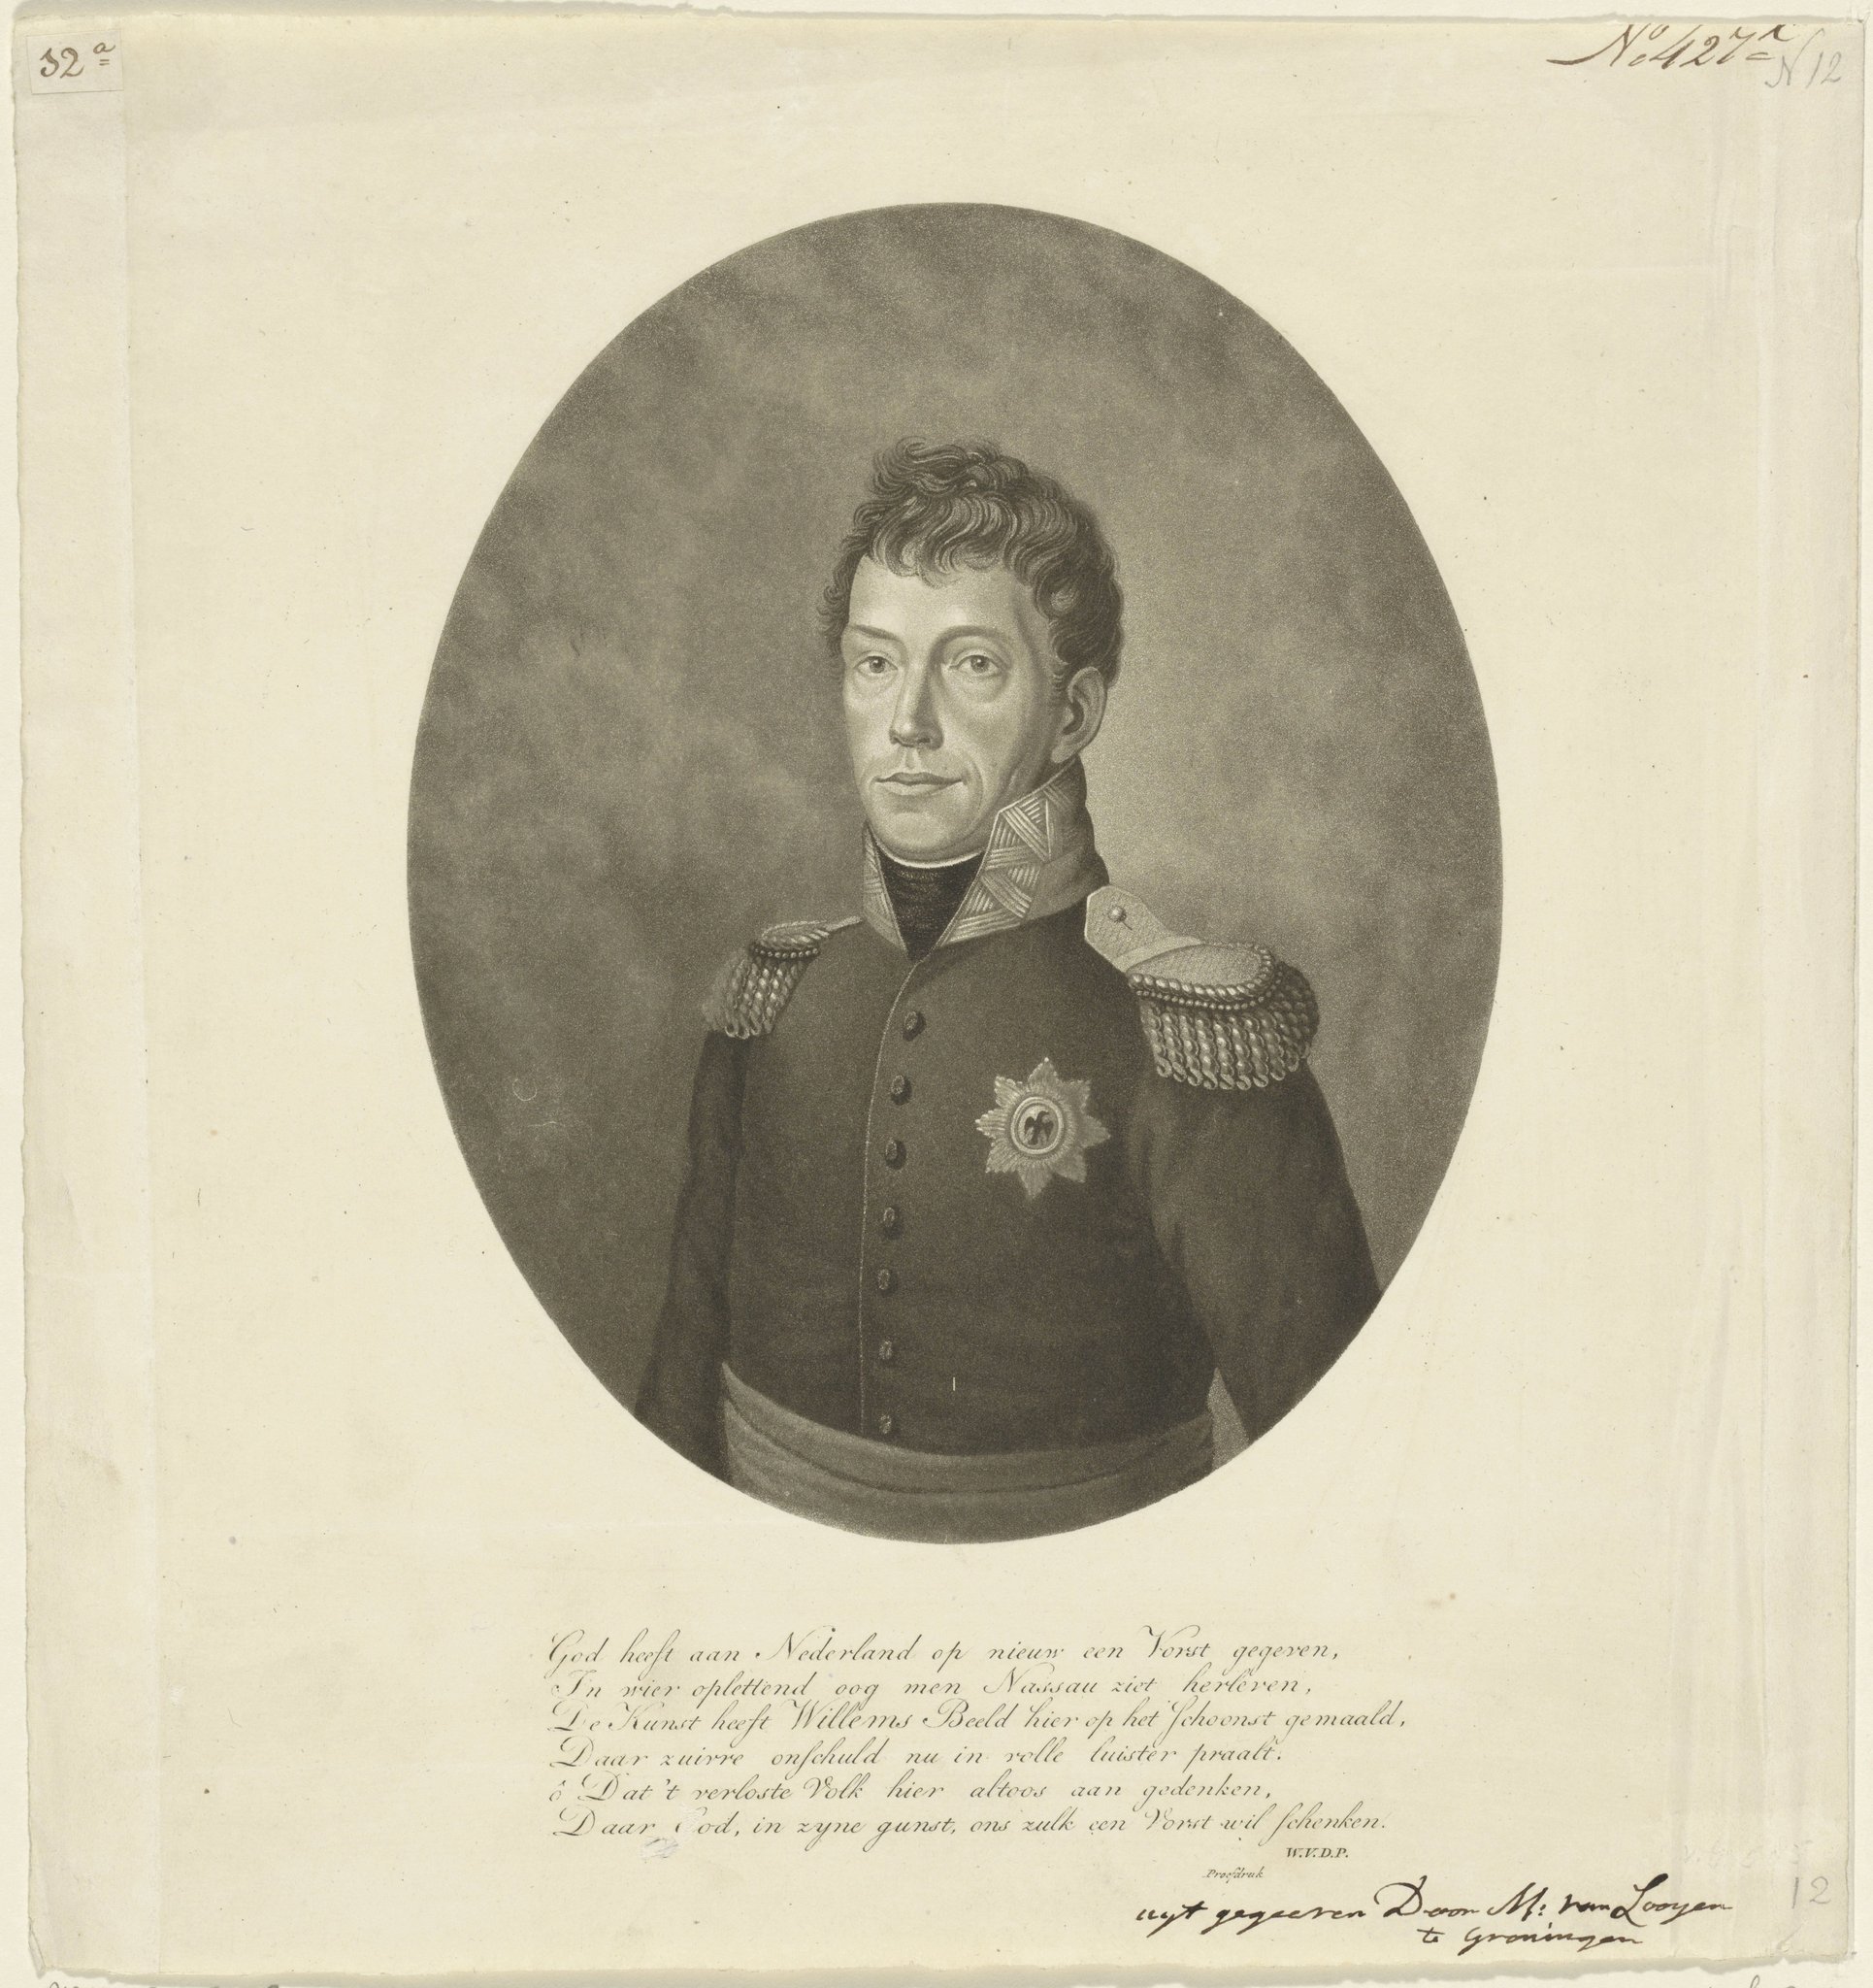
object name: print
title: Portret van Willem I Frederik, koning der Nederlanden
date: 1815-1899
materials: paper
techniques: aquatint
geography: amsterdam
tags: the hague, berlin, william i of the netherlands, knighthood order (with name) - insignia of a knighthood order, e.g.: badge, chain (with name of order)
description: De hier vermelde titel verwijst naar de hoogst verkregen titel van de geportretteerde, niet per se naar de titel die de geportretteerde op deze voorstelling draagt.